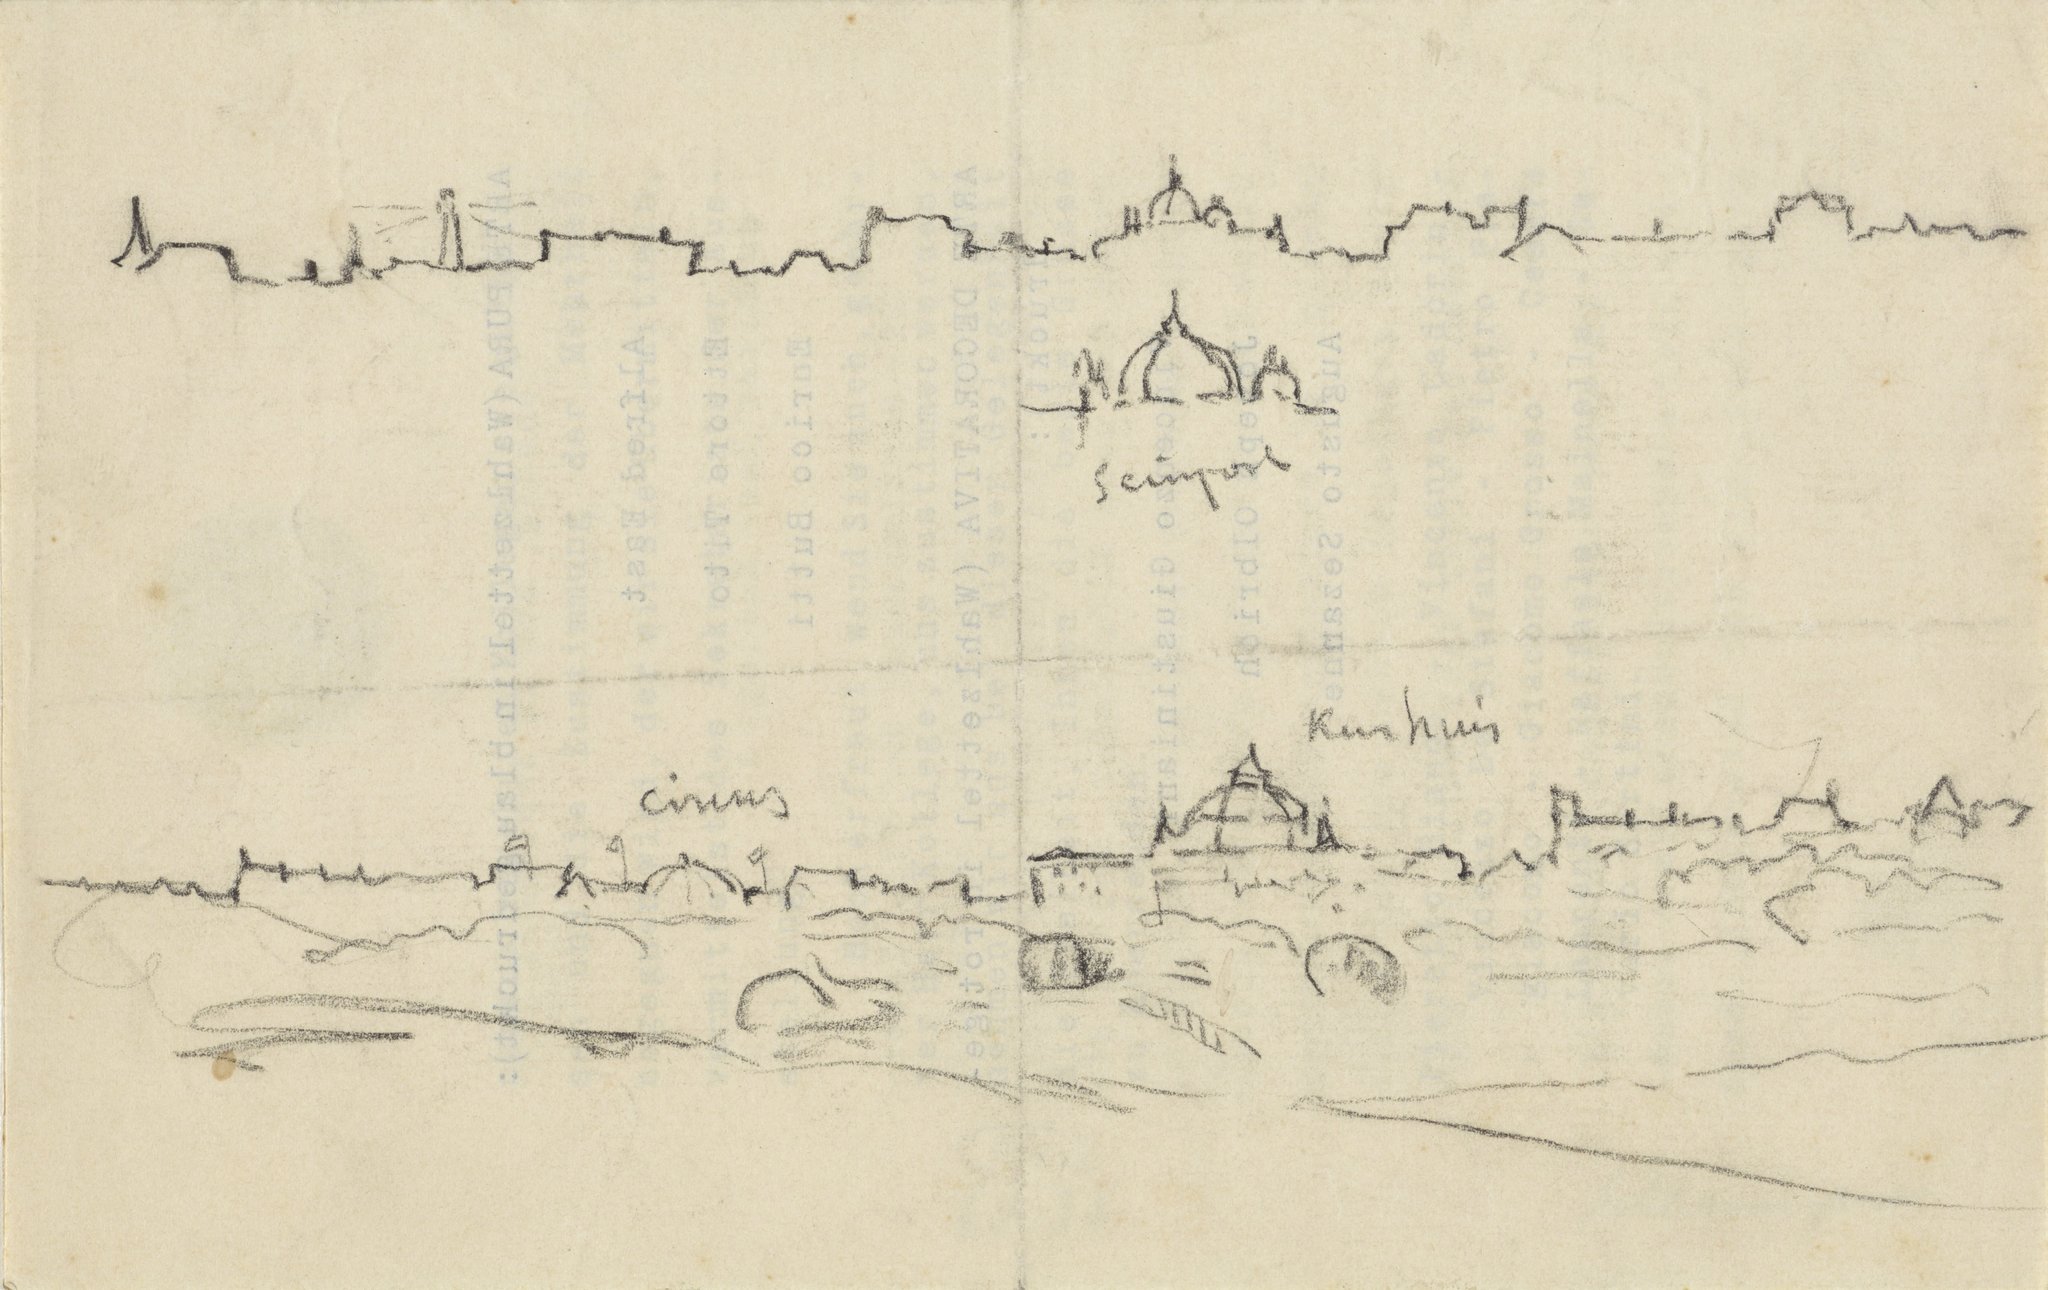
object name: drawing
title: Gezichten van Scheveningen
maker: adolf le comte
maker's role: draughtsman, painter, print maker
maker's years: 1850-1921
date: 1860-1921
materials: chalk, paper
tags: prospect of city, town panorama, silhouette of city